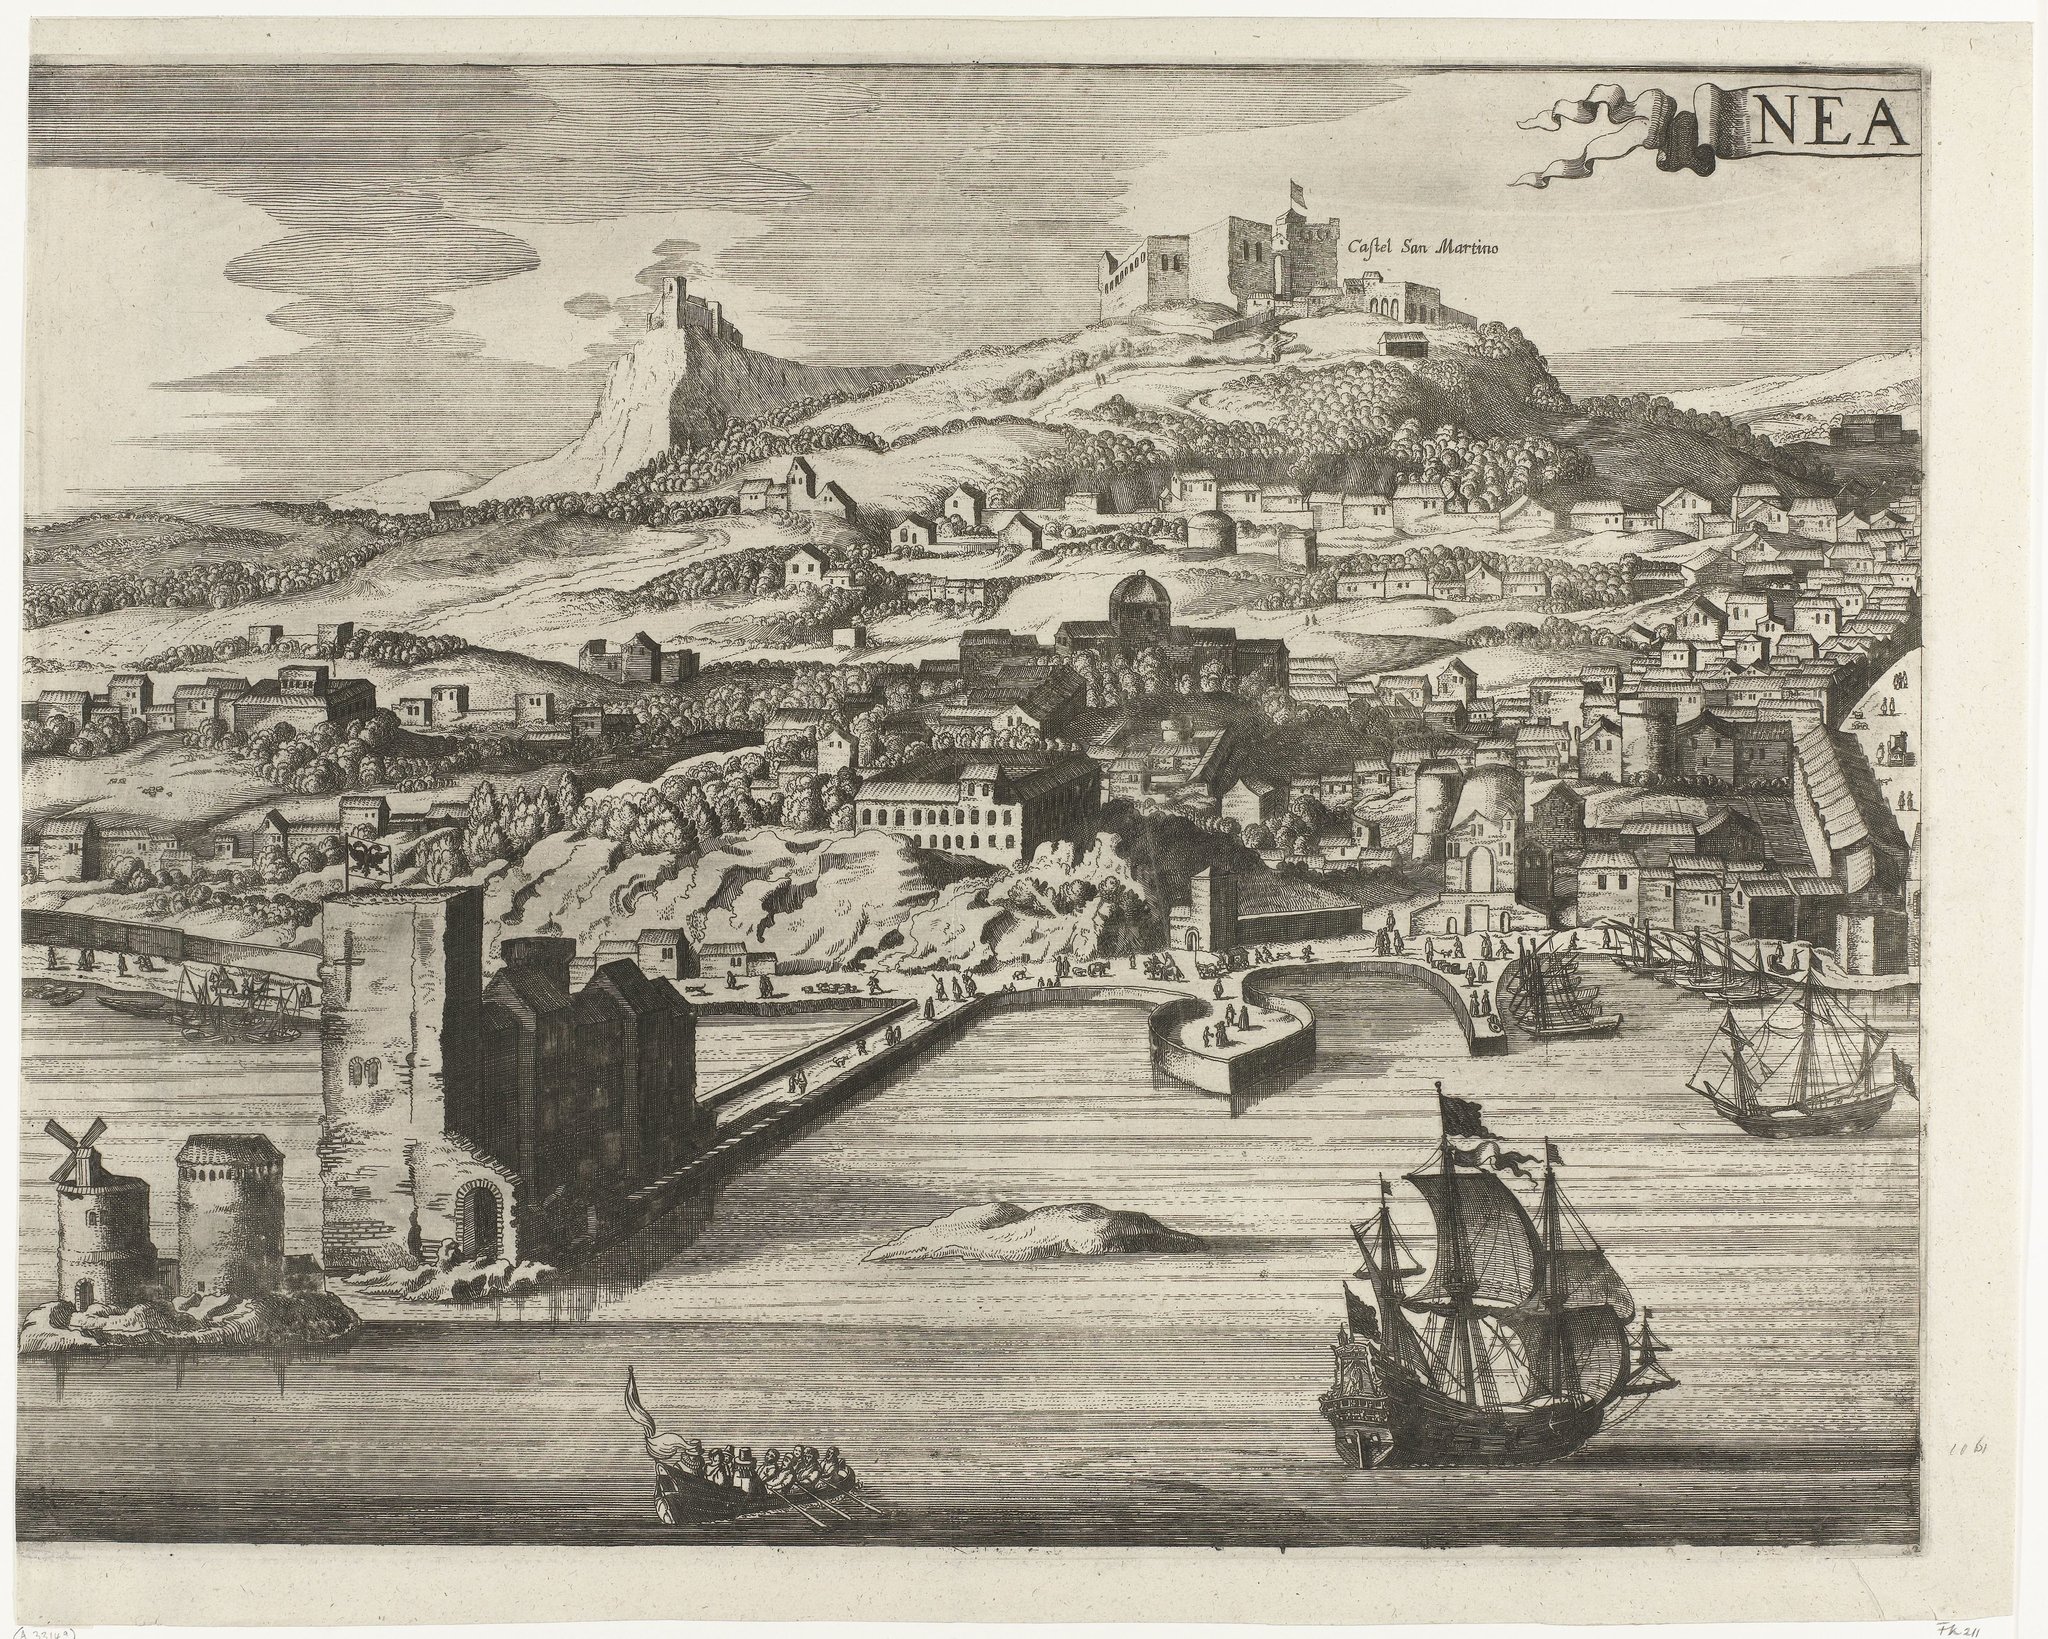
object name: print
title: Gezicht op Napels (blad 2)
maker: jan van de velde (ii)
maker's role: draughtsman, painter, print maker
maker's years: 1593-1641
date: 1618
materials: paper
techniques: etching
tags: prospect of city, town panorama, silhouette of city, naples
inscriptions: collector's mark: Lugt 2228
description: Linker middenblad van een fries van vier bladen met een gezicht op Napels, gedrukt van vier platen. In het midden Certosa San Martino.